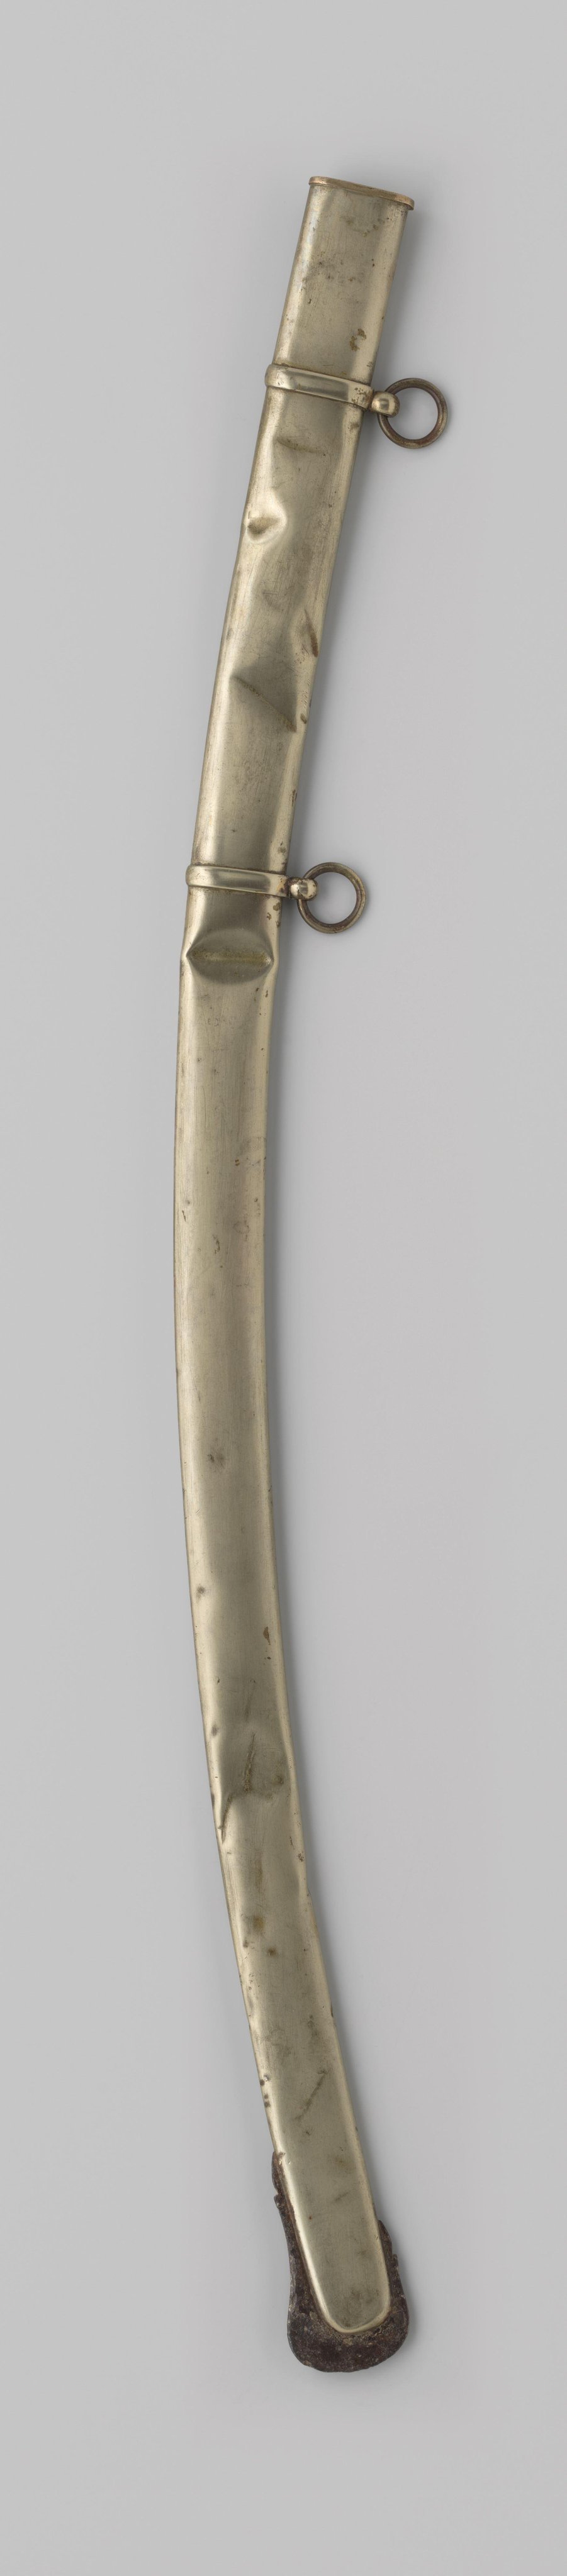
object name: sabre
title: Cavaleriesabel zonder gevest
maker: Anonymous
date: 1800-1900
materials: iron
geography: western europe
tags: west-europa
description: 19e Eeuwse cavaleriesabel zonder gevest. Schede heeft een zilverachtige gloed. Aan de schede zitten twee draagbanden met twee losse ringen. Onderaan de schede een verroeste sleepplaat.